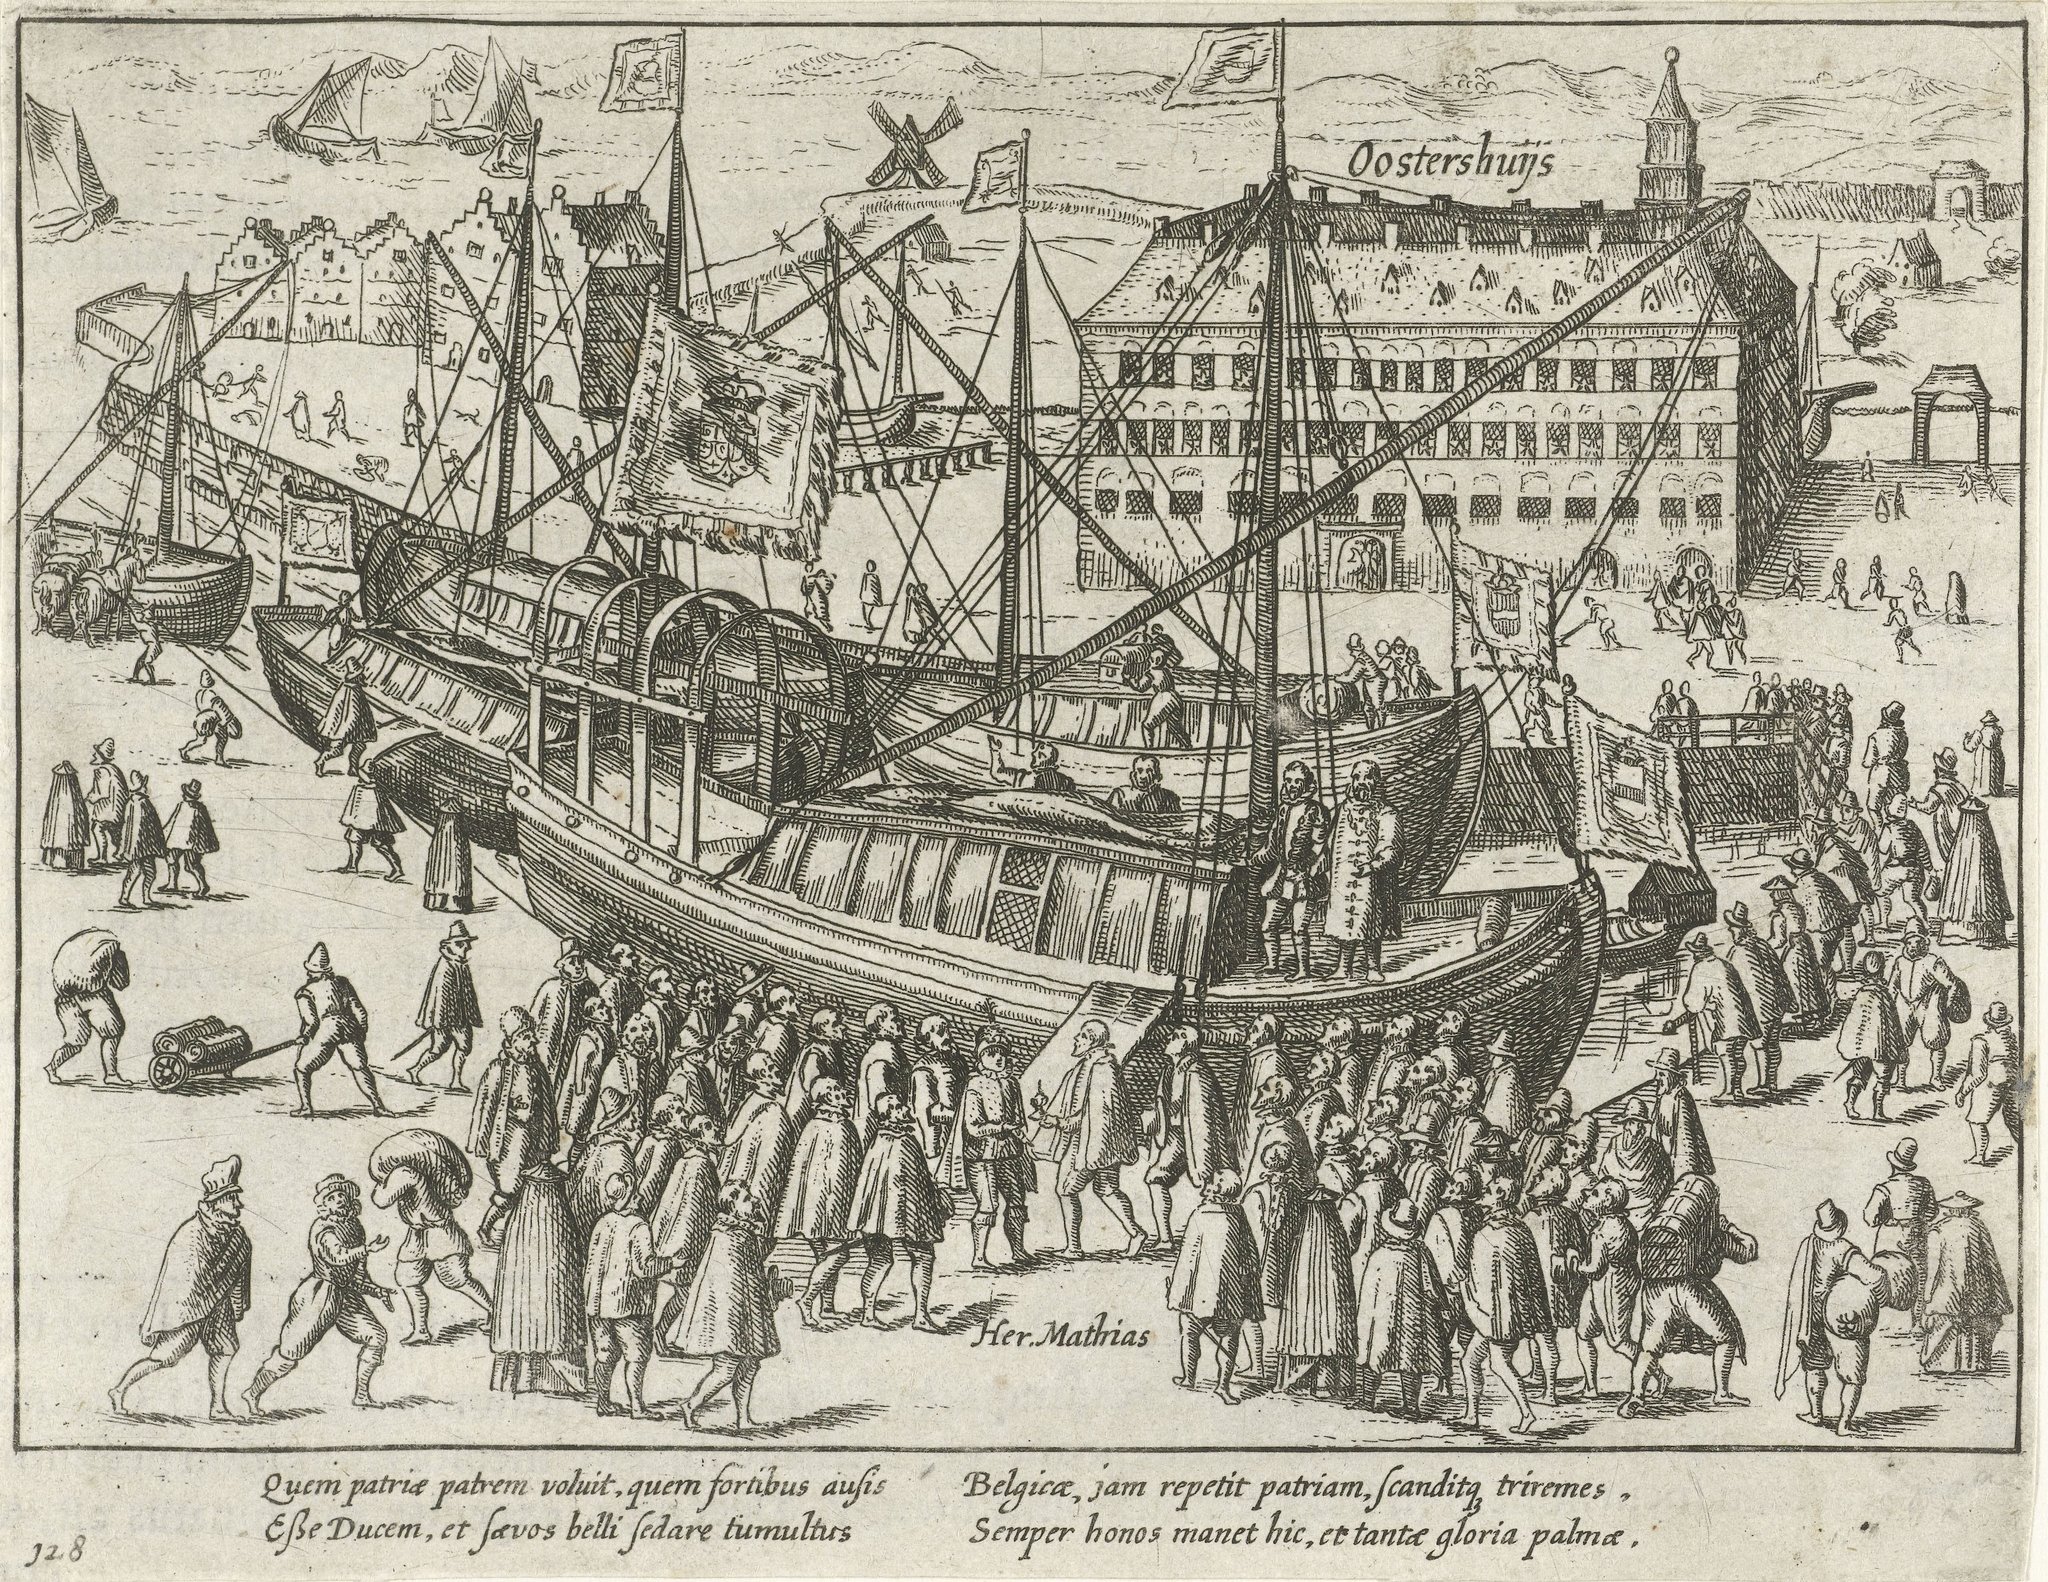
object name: print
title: Aartshertog Matthias vertrekt uit de Nederlanden, 1581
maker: Anonymous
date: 1613-1615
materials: paper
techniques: etching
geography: northern netherlands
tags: matthias van oostenrijk (rooms-duits keizer), departure ~ travelling (+ propulsion of vehicle, ship, etc. by wind)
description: Het vertrek van aartshertog Matthias uit de Nederlanden, 29 oktober 1581. Matthias neemt afscheid op de kade van Antwerpen bij een gereed staand schip met vaandels. Op de achtergrond het Oosters Huis. Met onderschrift van 4 regels in het Latijn. Genummerd 128. Bedrukt op achterzijde met tekst in het Latijn.